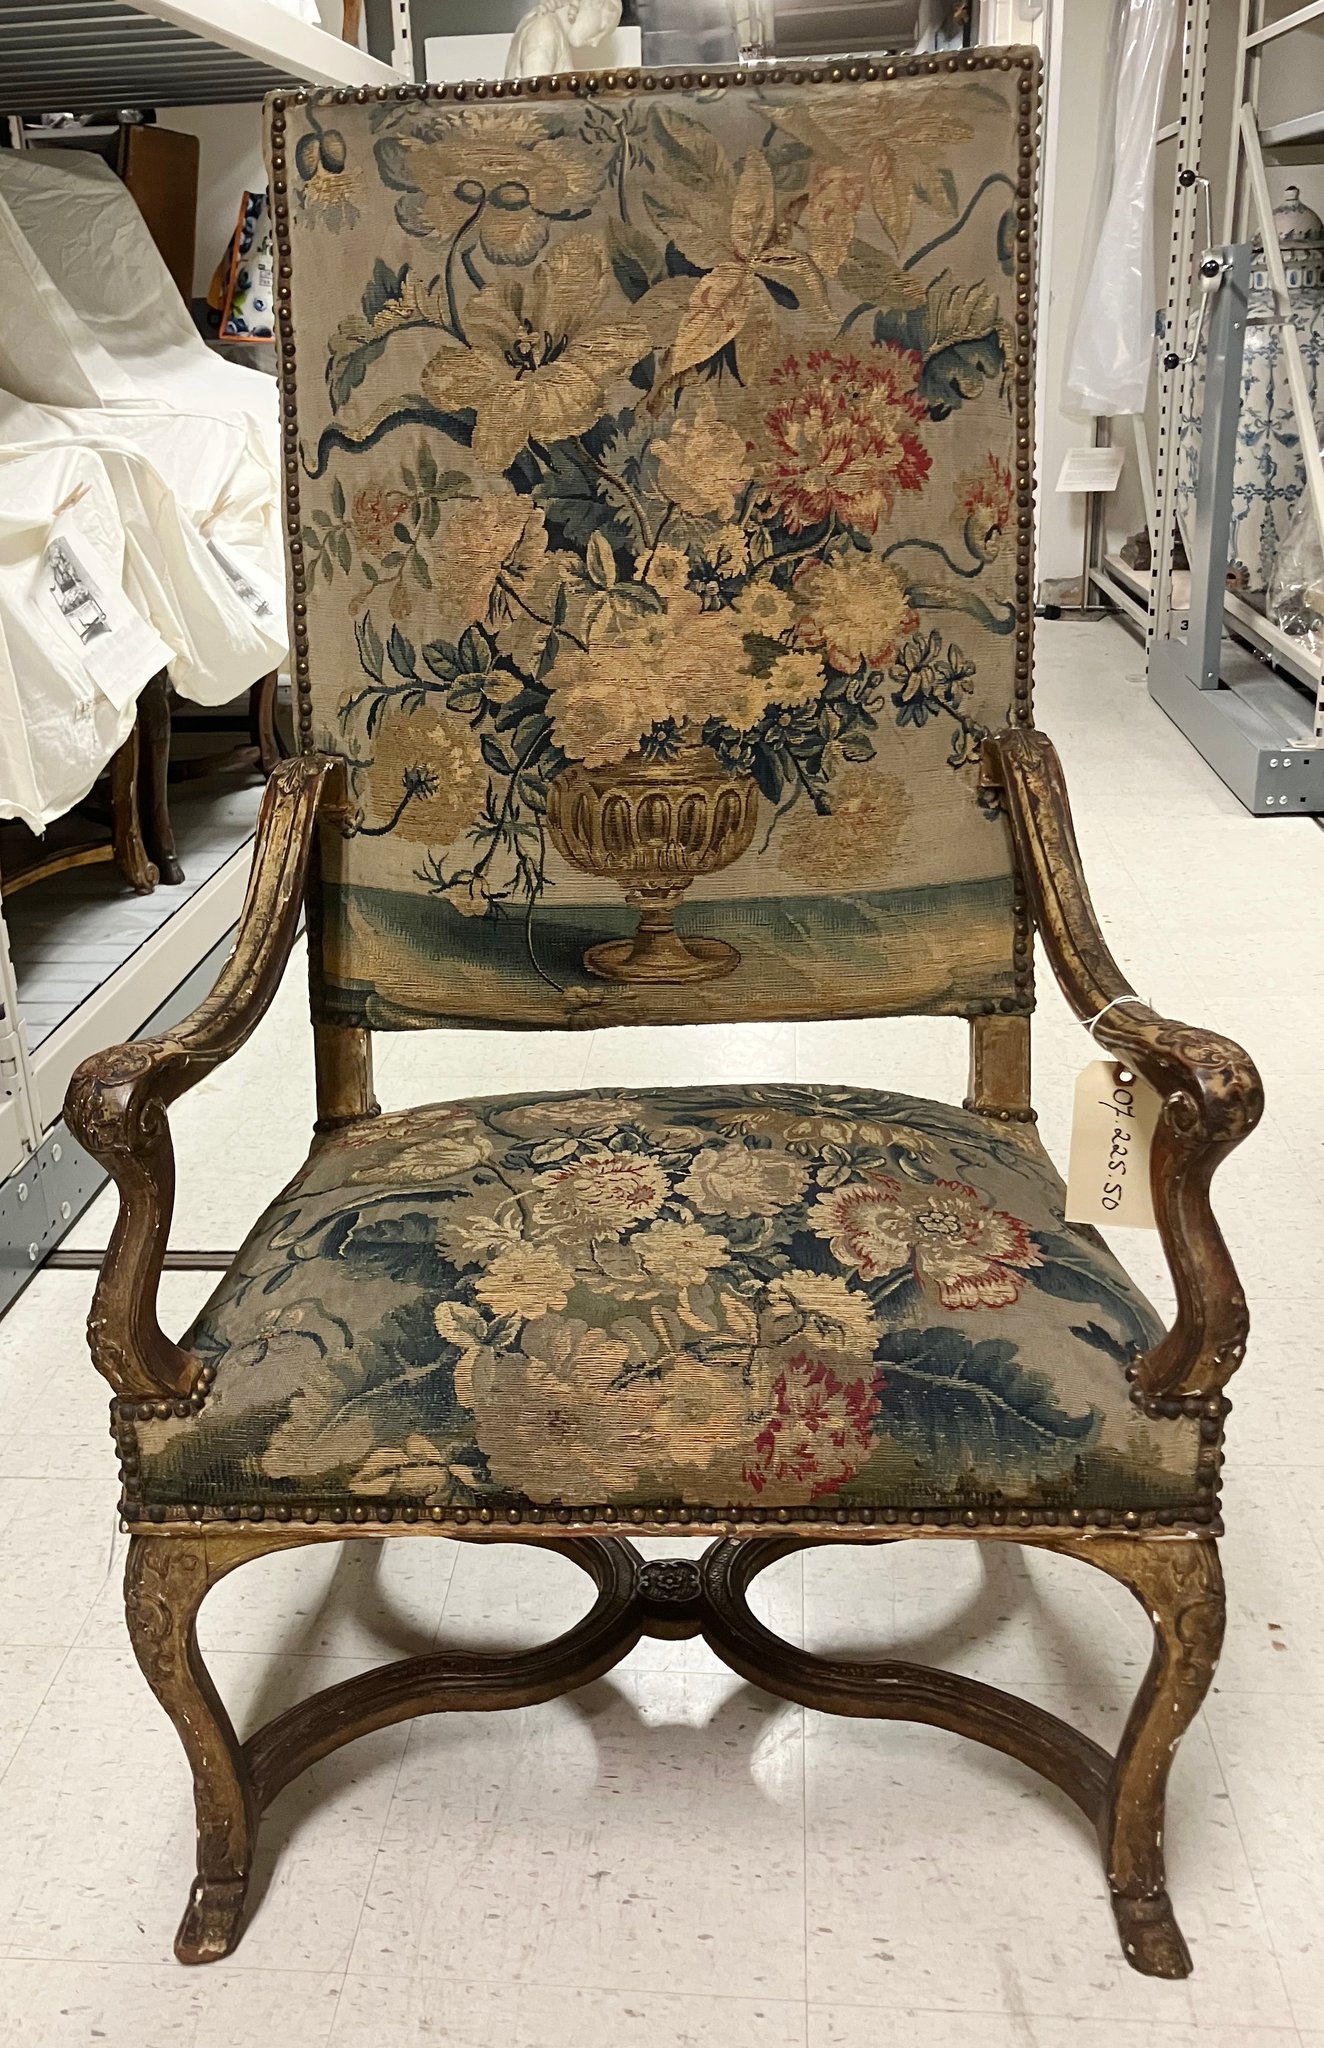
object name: armchair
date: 1667-1700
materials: wood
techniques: carving, gilding